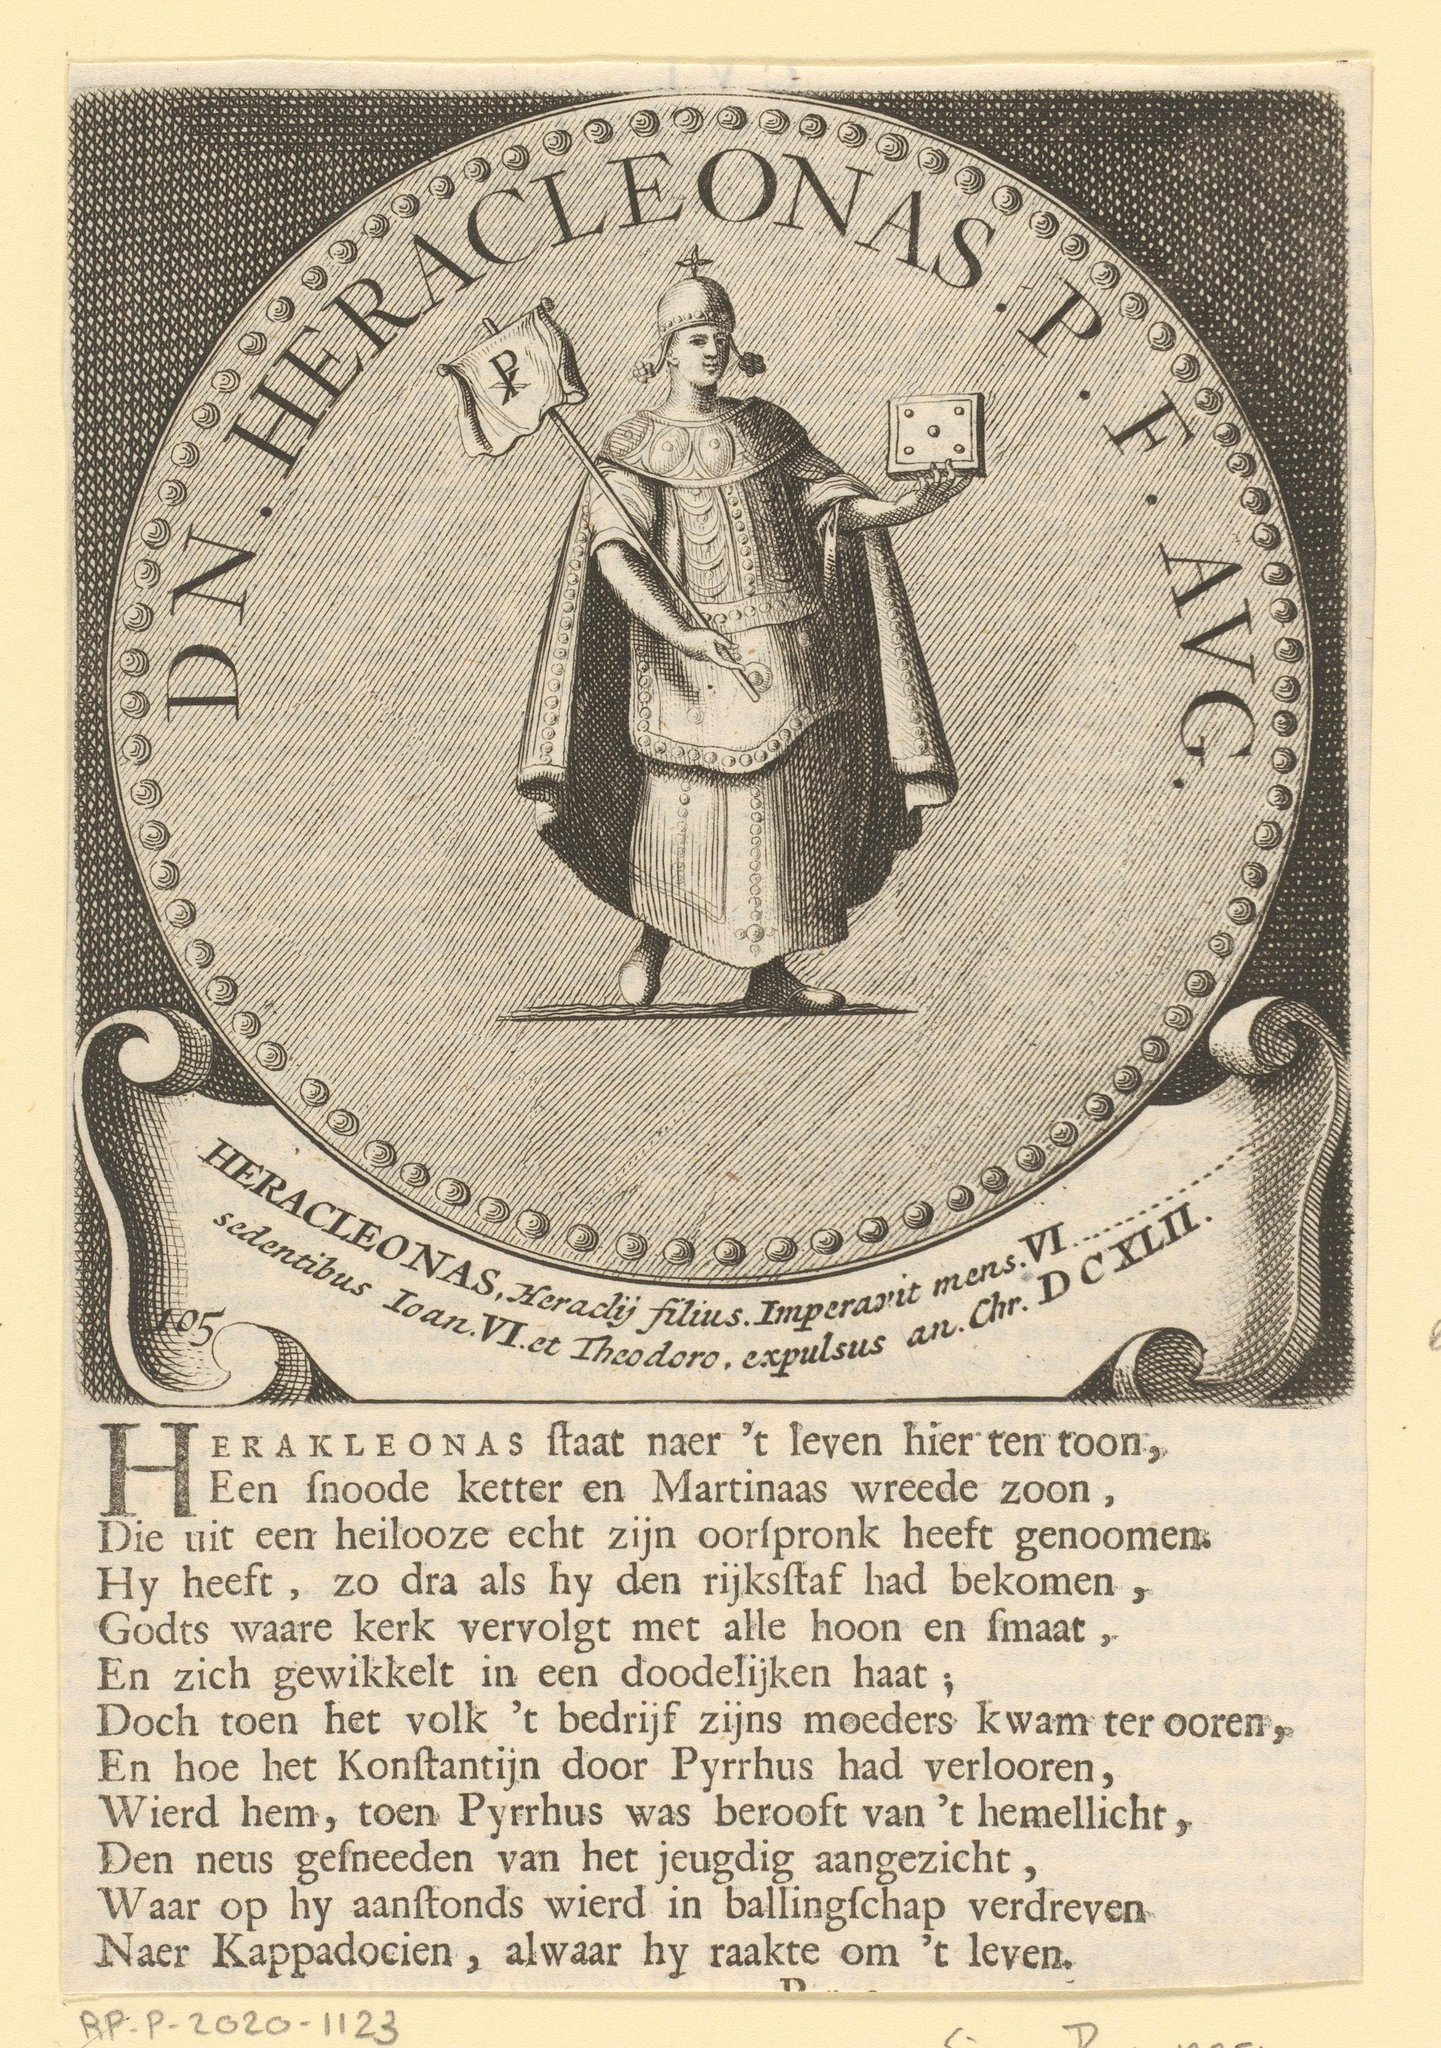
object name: book illustration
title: Heracleonas, Heraclii filius (...)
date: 1697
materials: paper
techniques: engraving, etching, letterpress printing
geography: utrecht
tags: historical persons, emperor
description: Prent uit: Bogaert, Abraham. De Roomsche monarchy, vertoont in de muntbeelden der westersche en oostersche keizeren (...). Utrecht: François Halma en Willem van de Water, 1697, p. 317. Eerste staat verschenen in een grotere prent met twaalf portretten, gedateerd 1695.